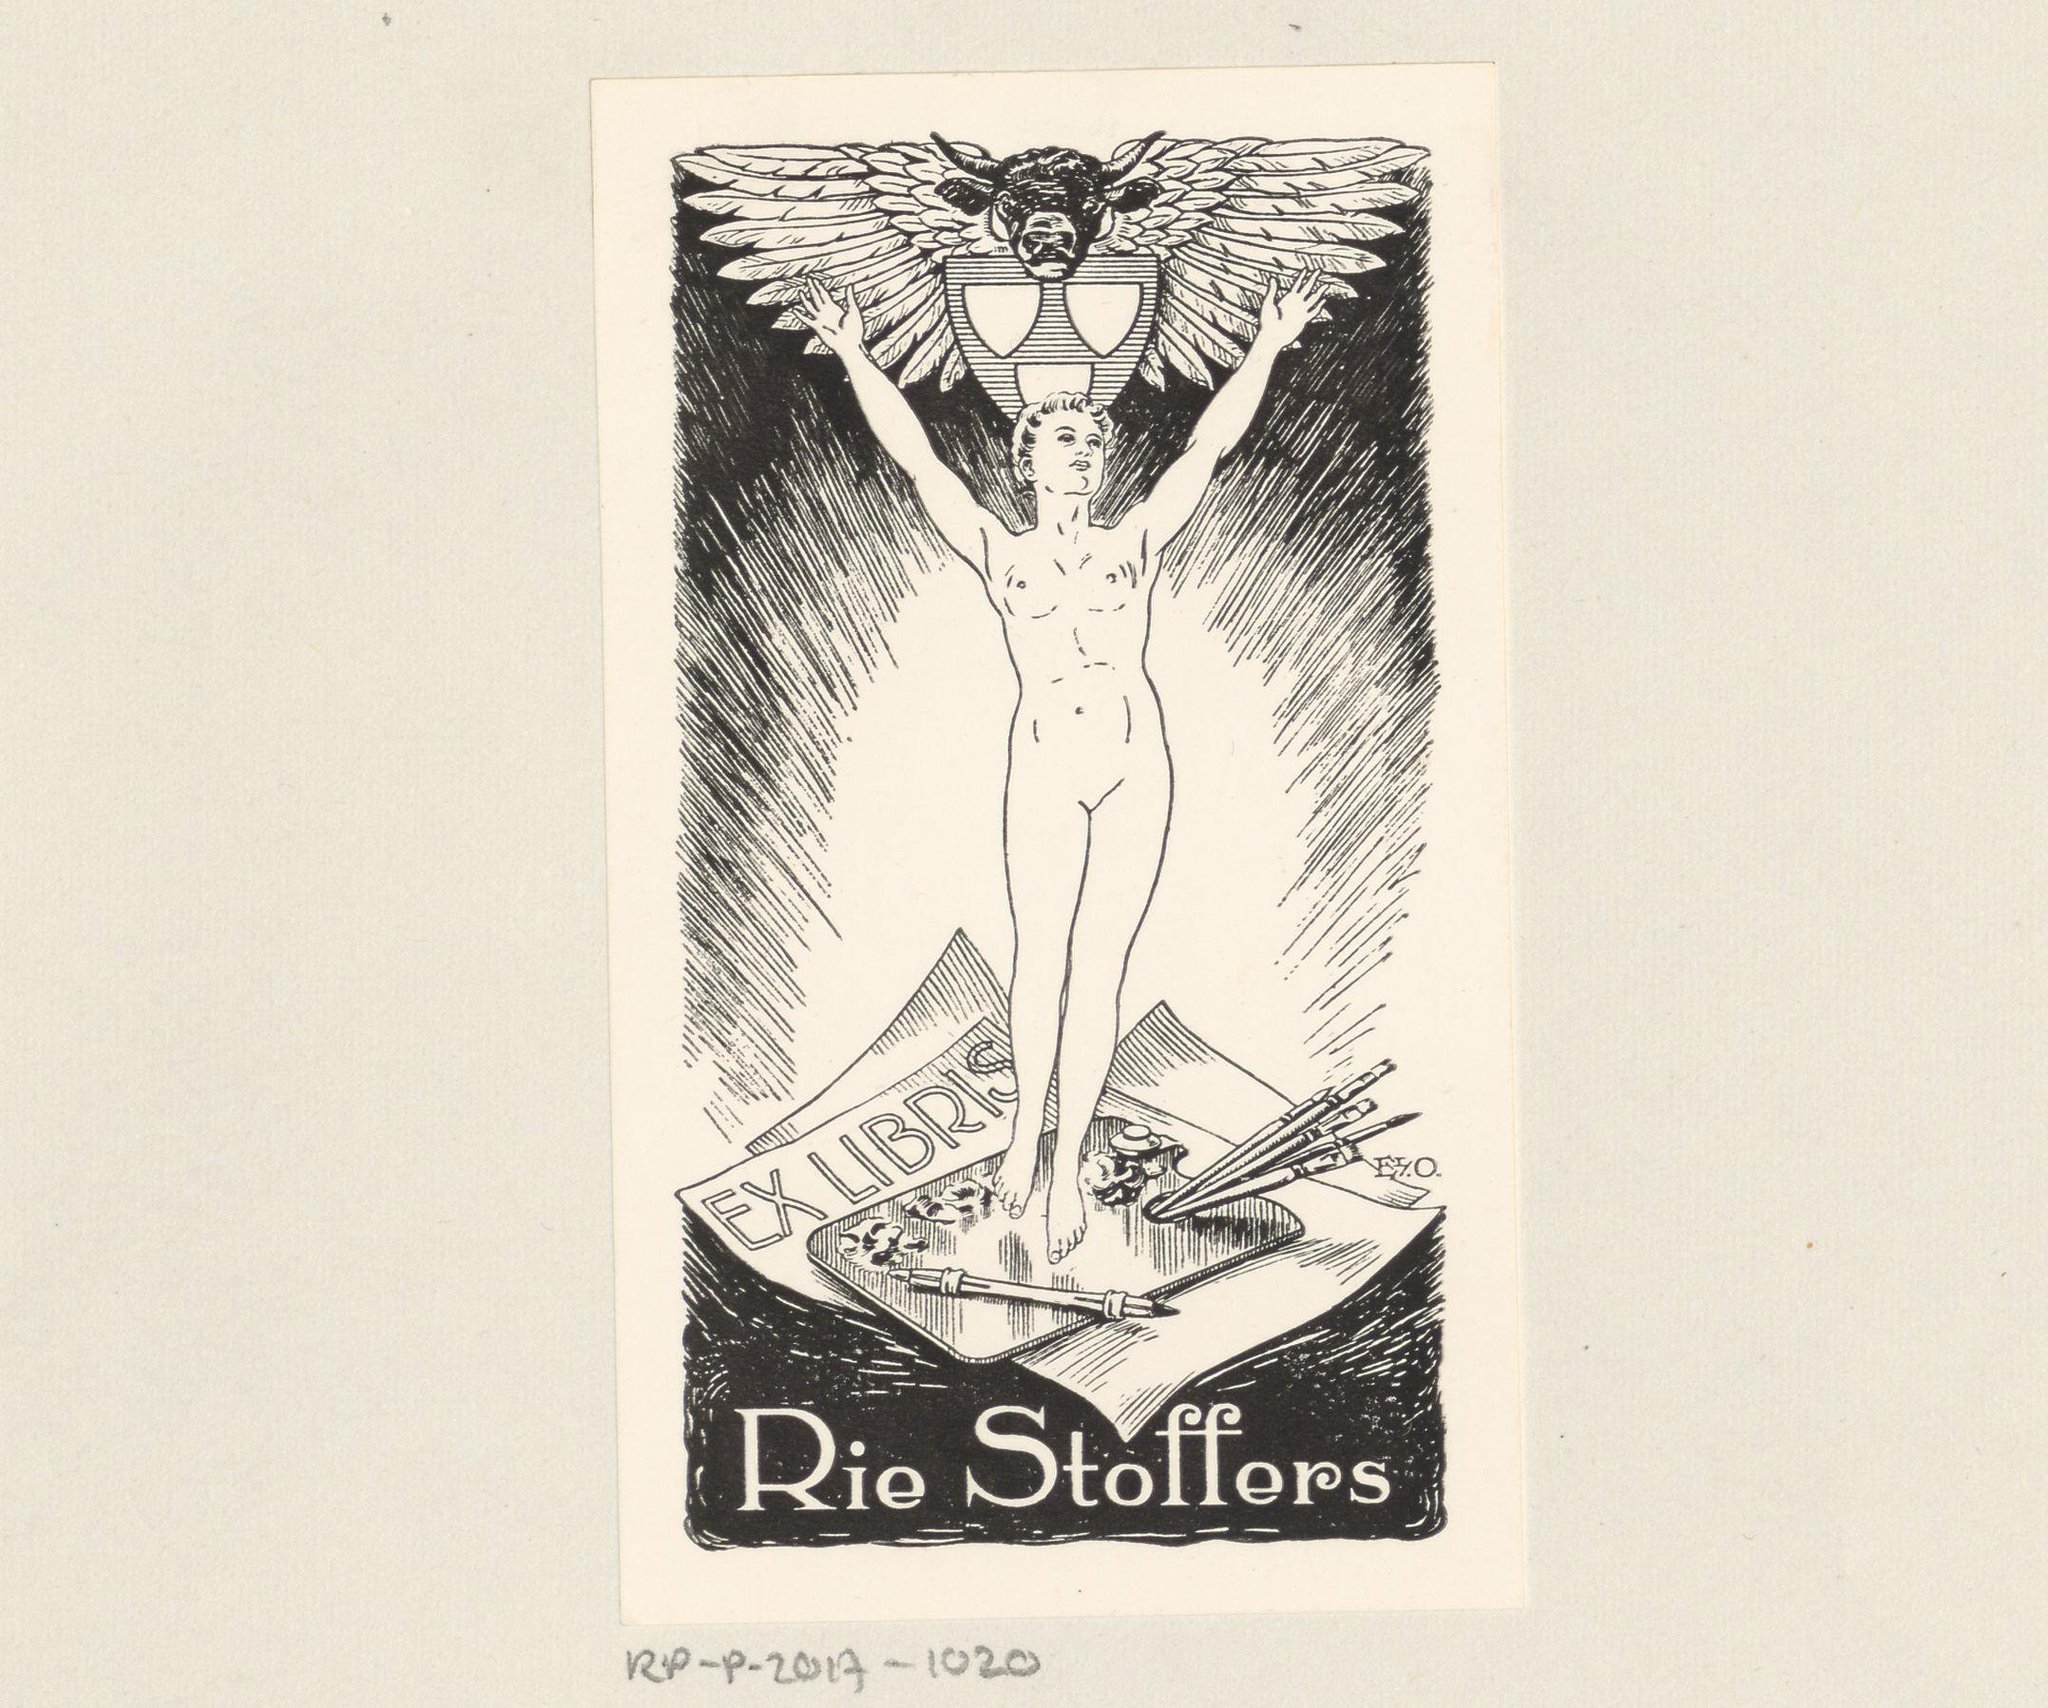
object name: bookplate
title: Ex libris van Rie Stoffers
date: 1946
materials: paper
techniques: printing block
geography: amsterdam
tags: print maker, maria nunnikhoven-stoffers (rie), st. luke as patron of painters, ex-libris, woman (showing herself) undressed, quasi-nude, palette, armorial bearing, heraldry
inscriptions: signature, date and inscription: ‘Elias Ott / Nieuwer Amstel / Cl. 1946’